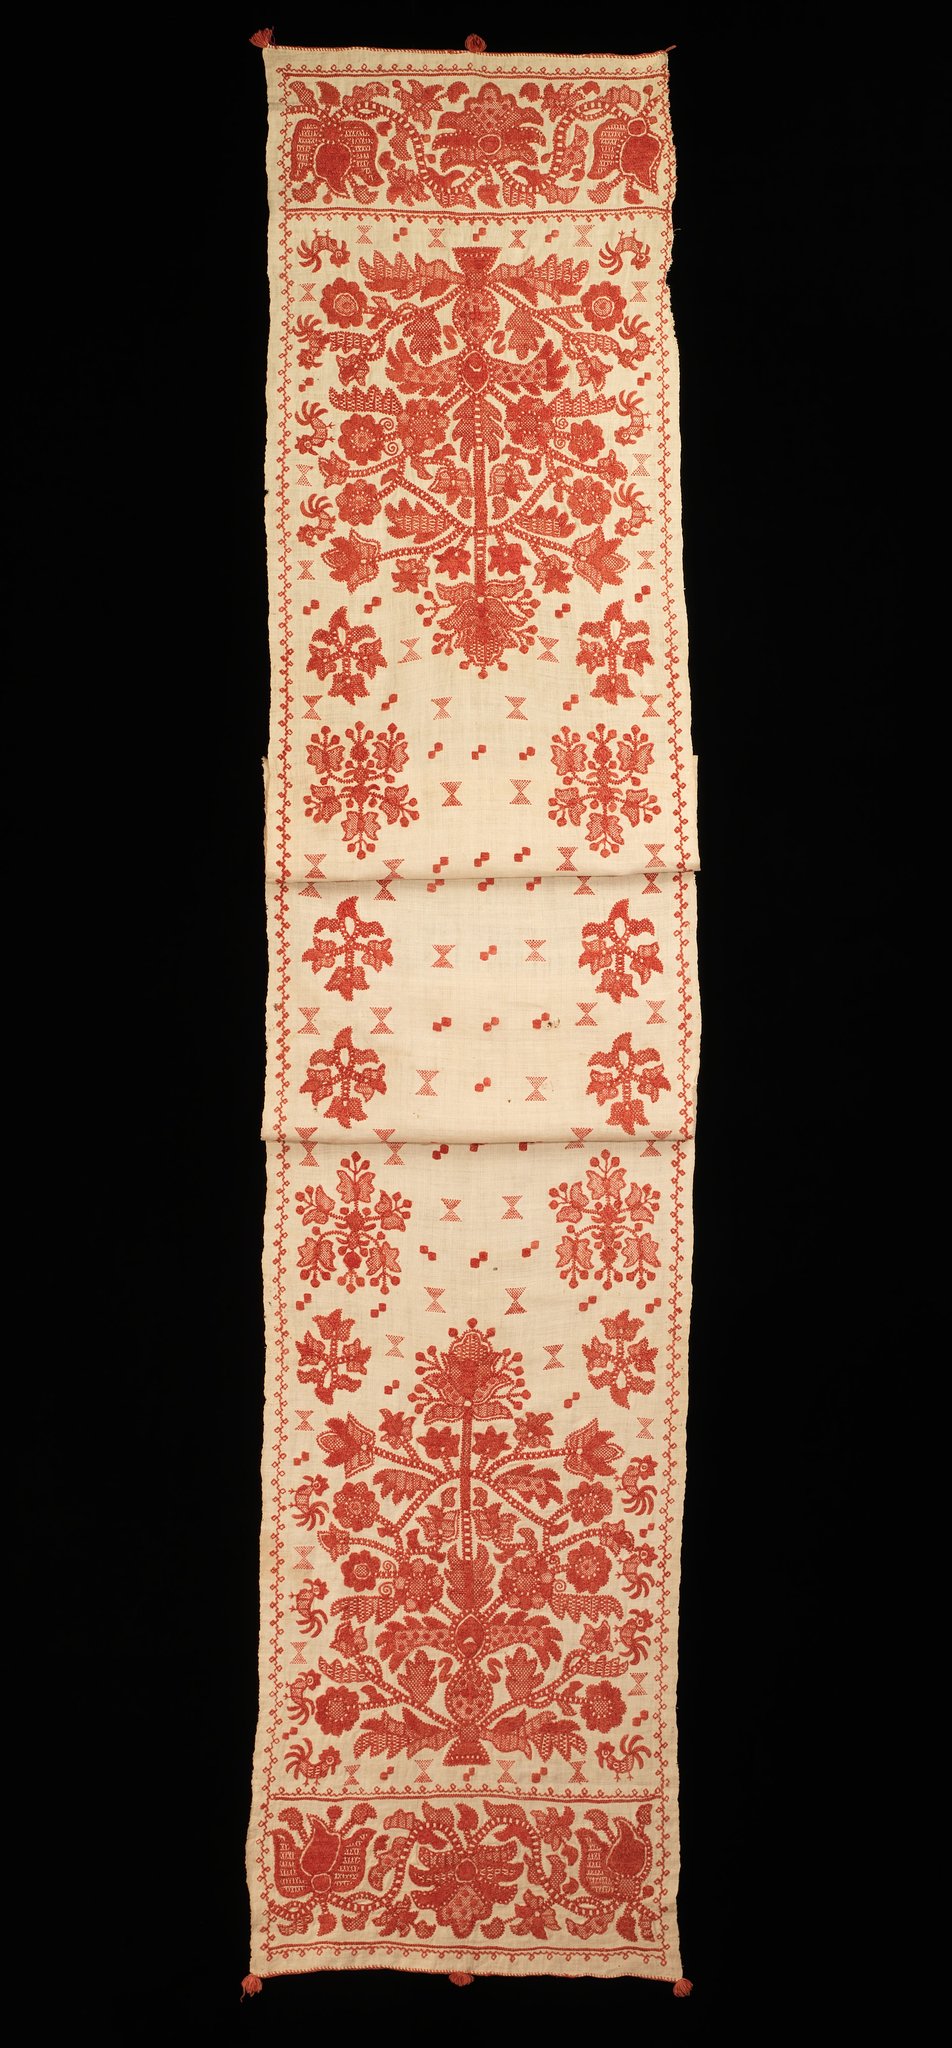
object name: towel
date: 1801-1833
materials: cotton, linen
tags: flowers